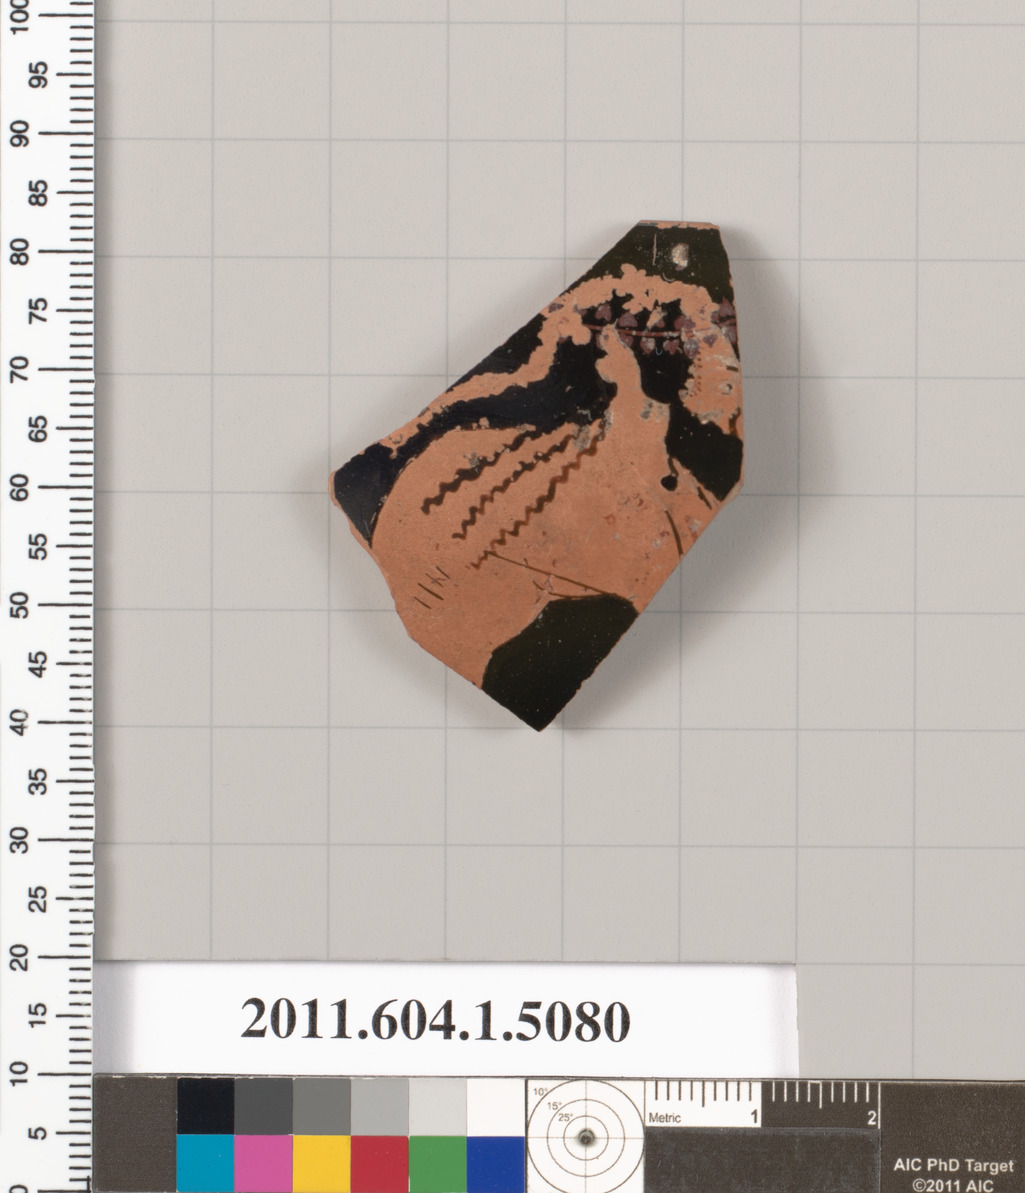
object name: kylix fragment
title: Terracotta rim fragment of a kylix (drinking cup)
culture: greek, attic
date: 510-500 BCE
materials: terracotta